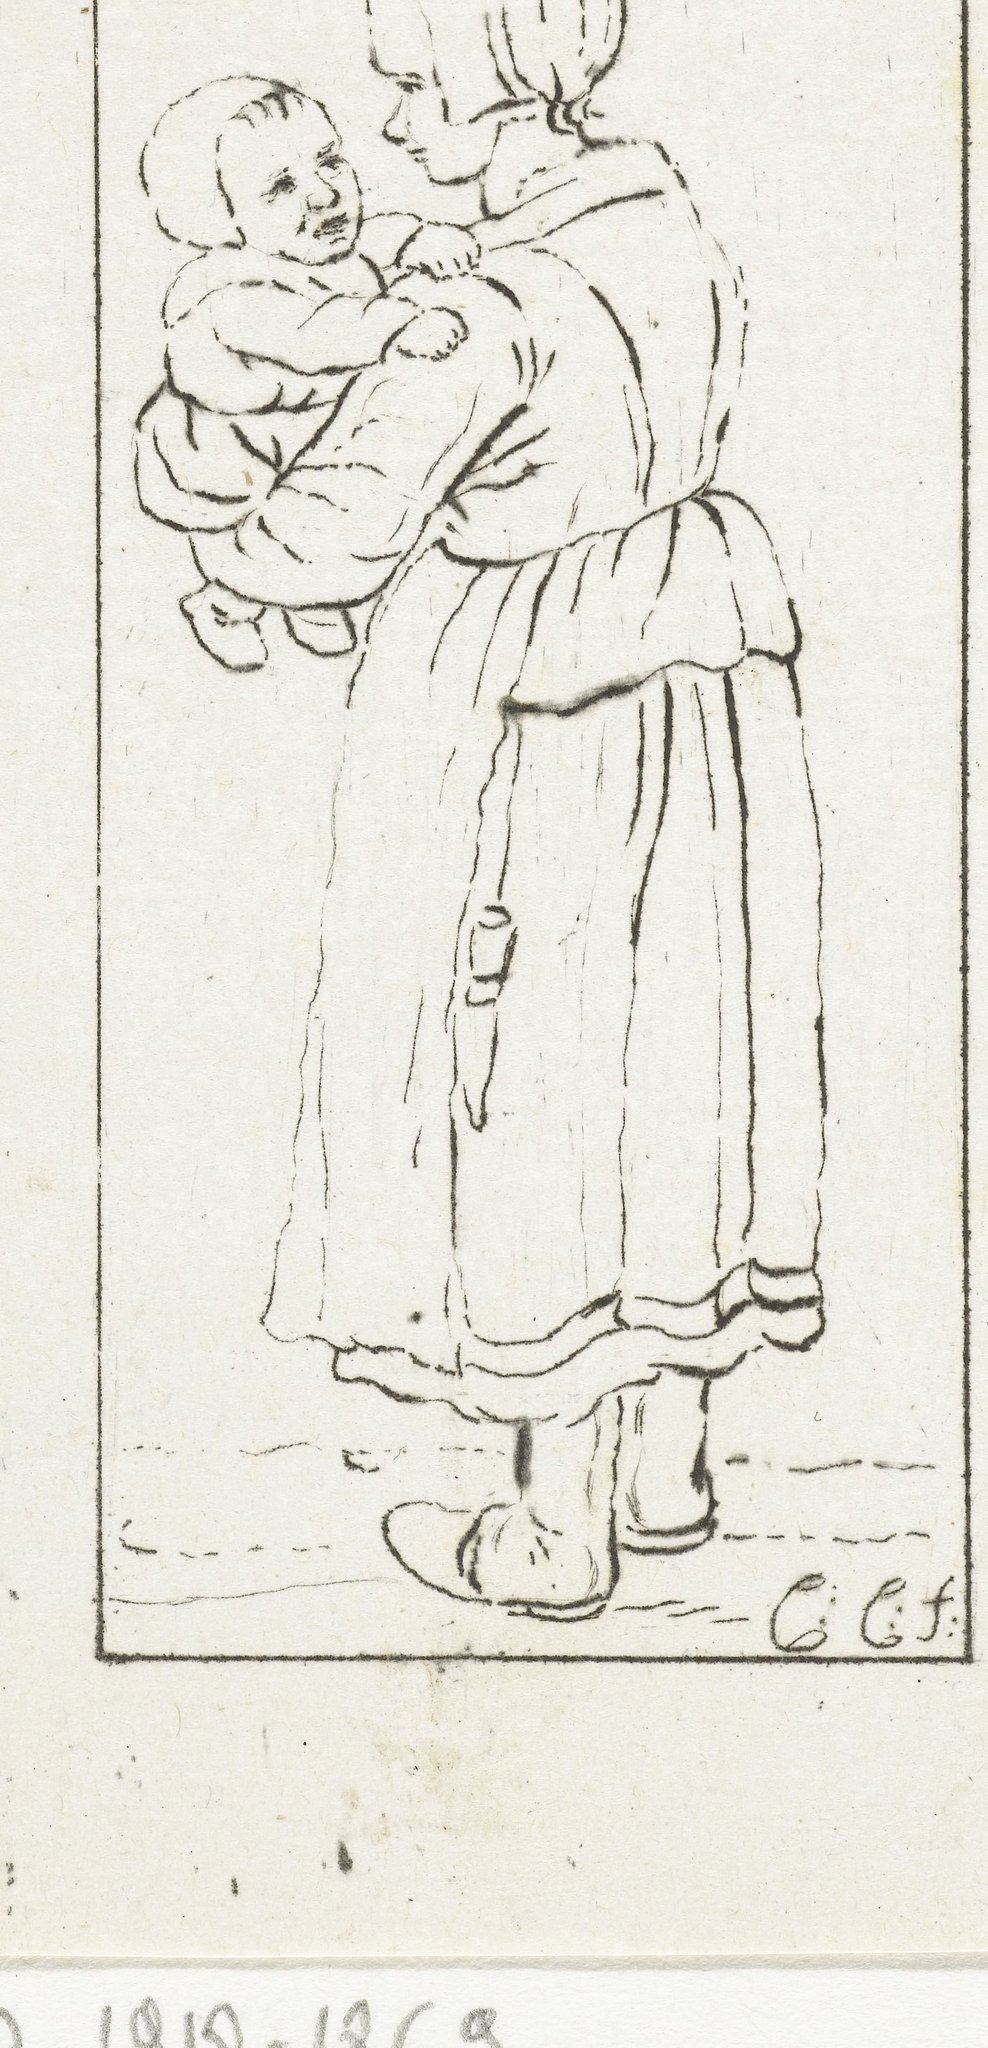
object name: print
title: Moeder met kind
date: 1779-1796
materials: paper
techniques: etching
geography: leiden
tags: mother and daughter(s) (family group) (with number of daughters)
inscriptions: collector's mark: Lugt 2233